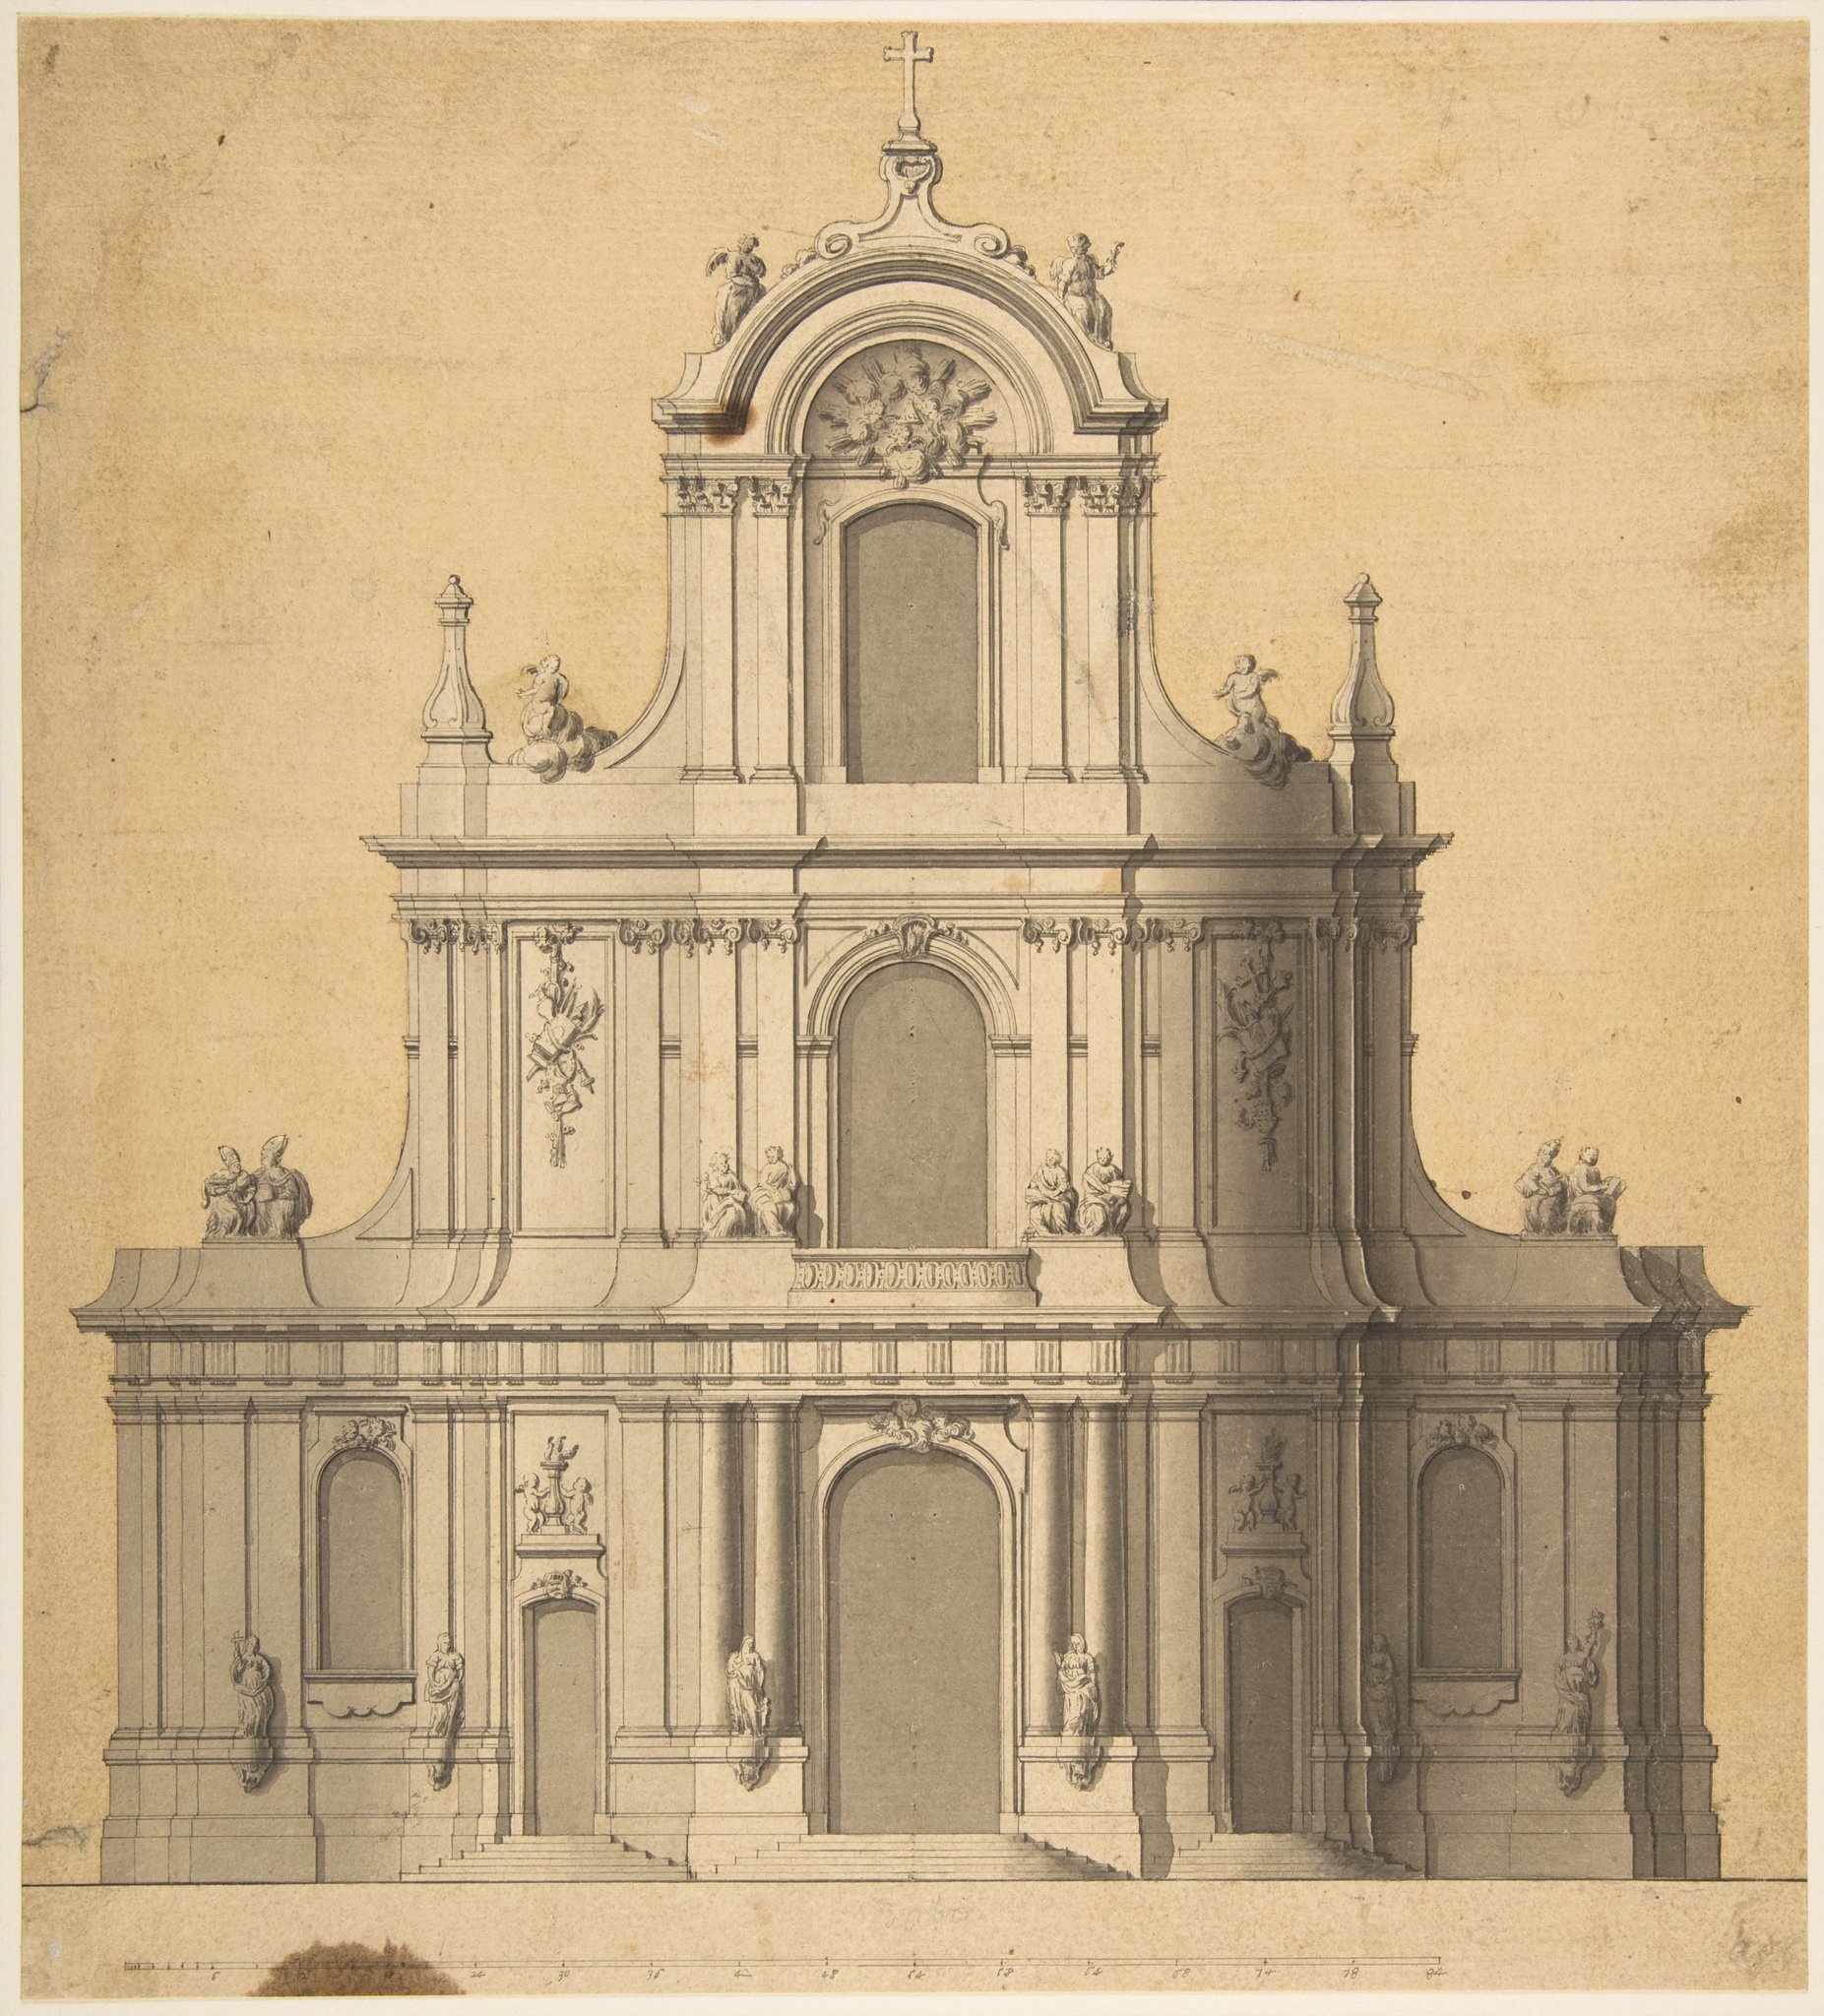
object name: drawing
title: Elevation of West Façade of a Church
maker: anonymous, french, 18th century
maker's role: artist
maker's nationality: french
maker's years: 1700-1800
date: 1701-1800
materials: ink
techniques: brush, pen, wash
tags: architecture,churches